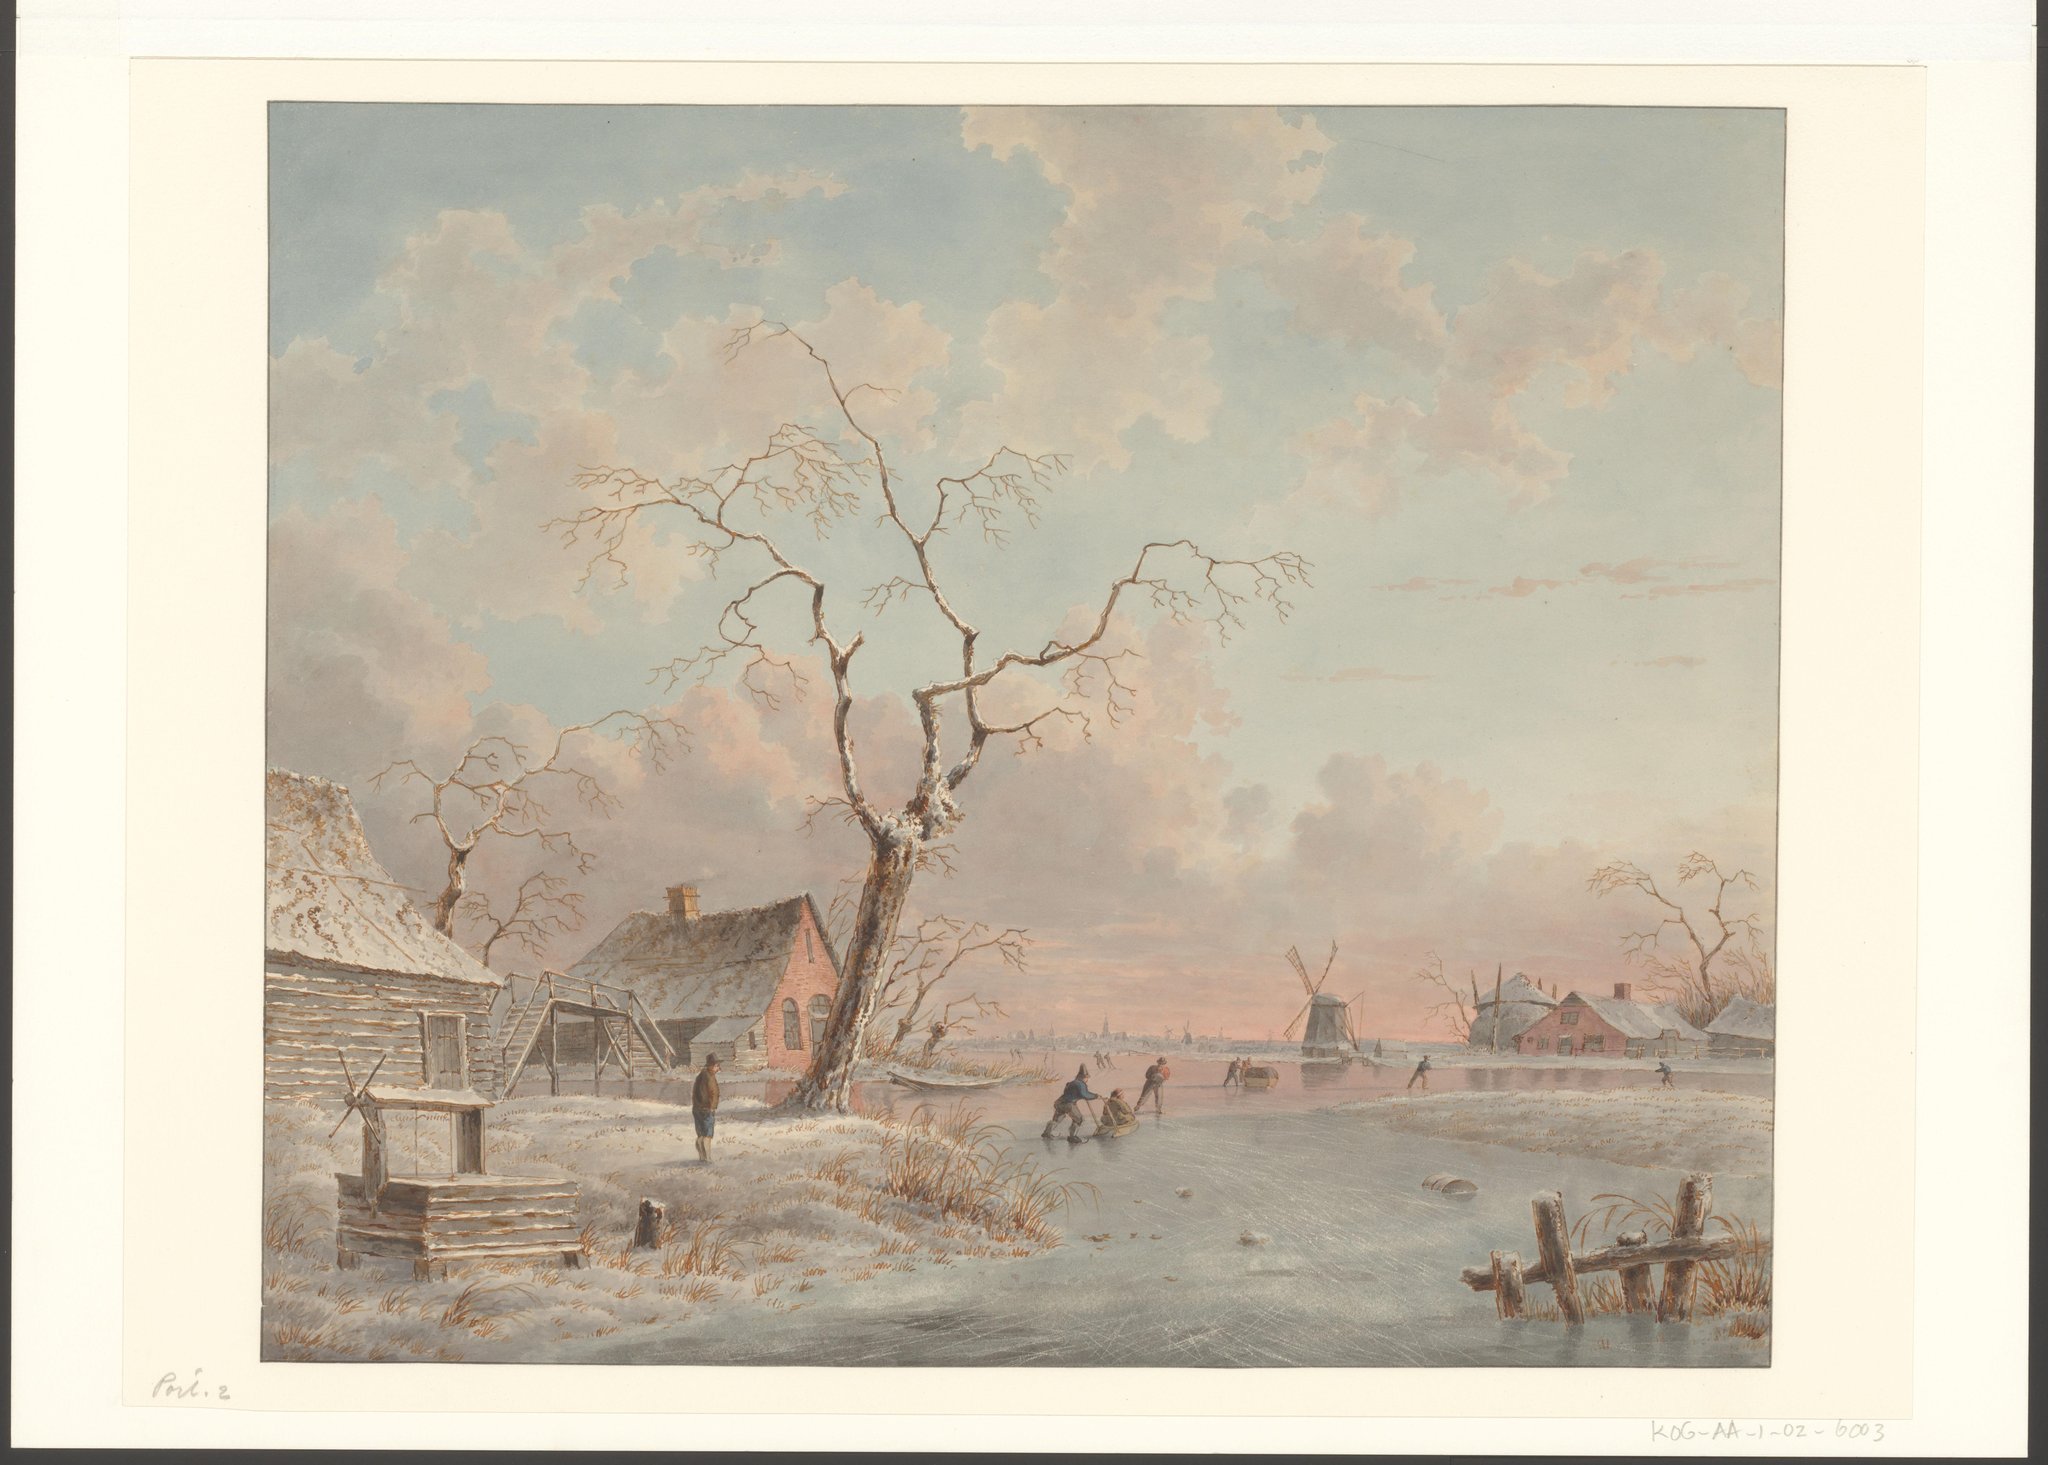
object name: drawing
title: Winterlandschap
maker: jan de beijer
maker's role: draughtsman, print maker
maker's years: 1703-1780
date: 1713-1780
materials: ink, paper, pencil, watercolor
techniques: brush, pen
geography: amsterdam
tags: city-view in general; 'veduta', winter landscape; landscape symbolizing winter (the four seasons of the year), amsterdam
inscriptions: inscription: ‘Port. 2’, inscription: ‘[...] G.J. van leeuwen’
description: Onderwerpsrubriek binnen de Atlas Amsterdam: Gezichten op de stad uit het Westen / Buiten de Haarlemmerpoort.